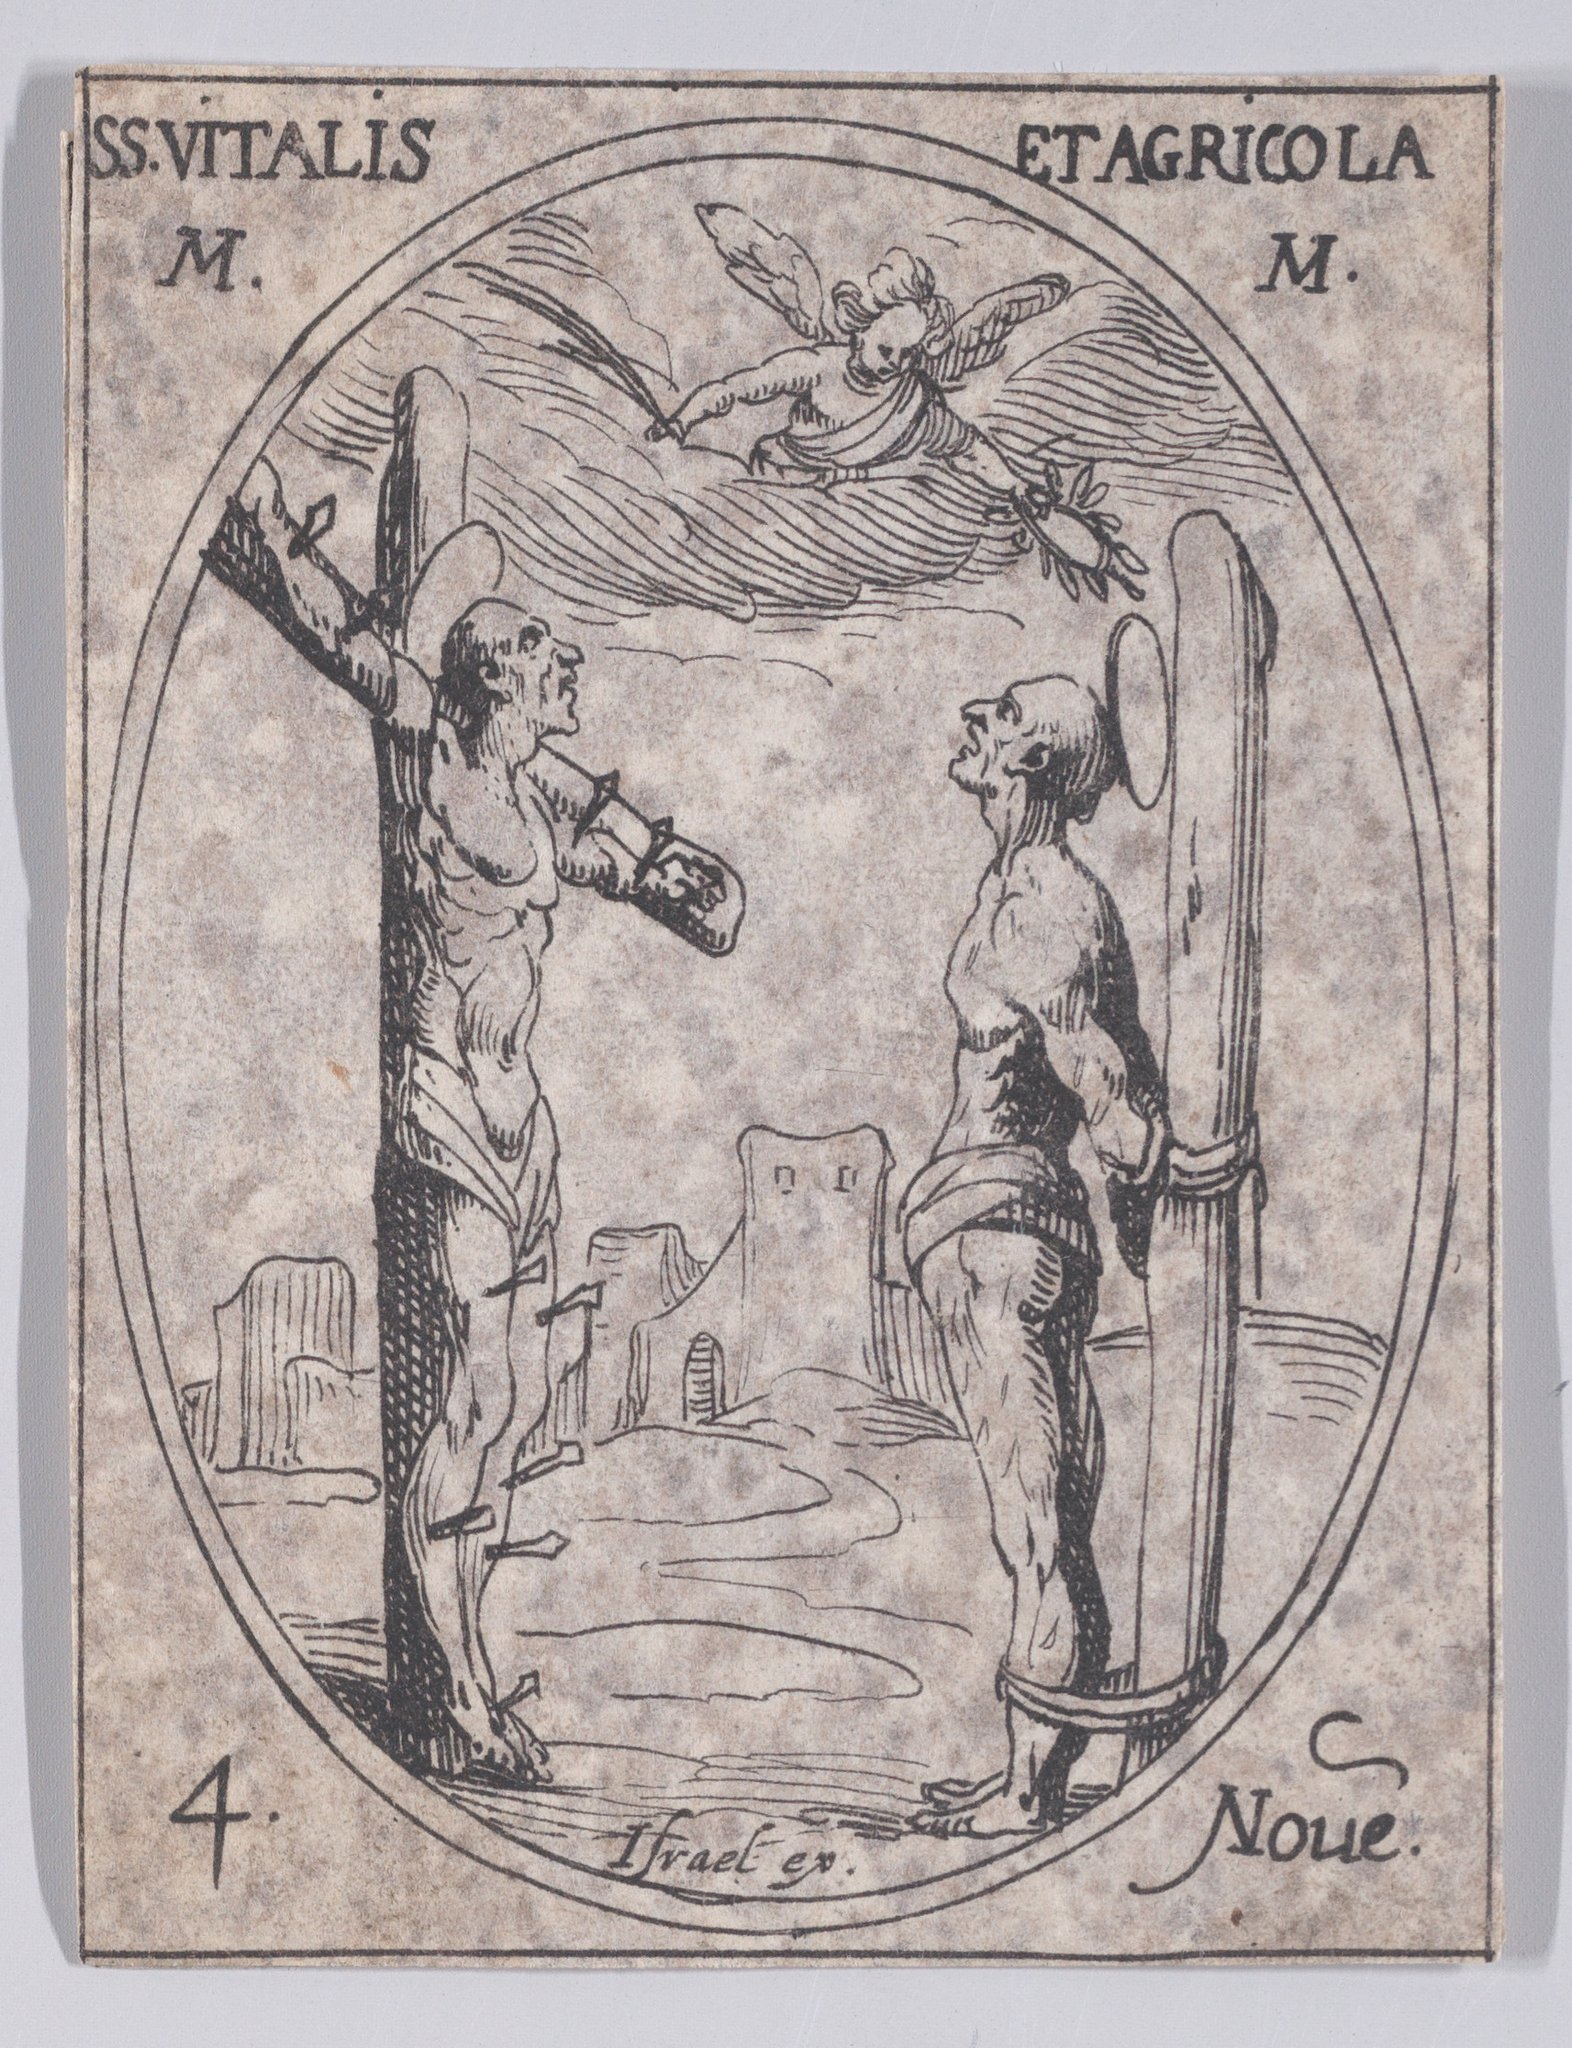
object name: print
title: S. Vital et S. Agricole (St. Vitalis and St. Agricola), November 4th, from "Les Images De Tous Les Saincts et Saintes de L'Année" (Images of All of the Saints and Religious Events of the Year)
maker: jacques callot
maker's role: artist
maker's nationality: french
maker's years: 1592-1635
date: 1636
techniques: etching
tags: men,crucifixion,saints